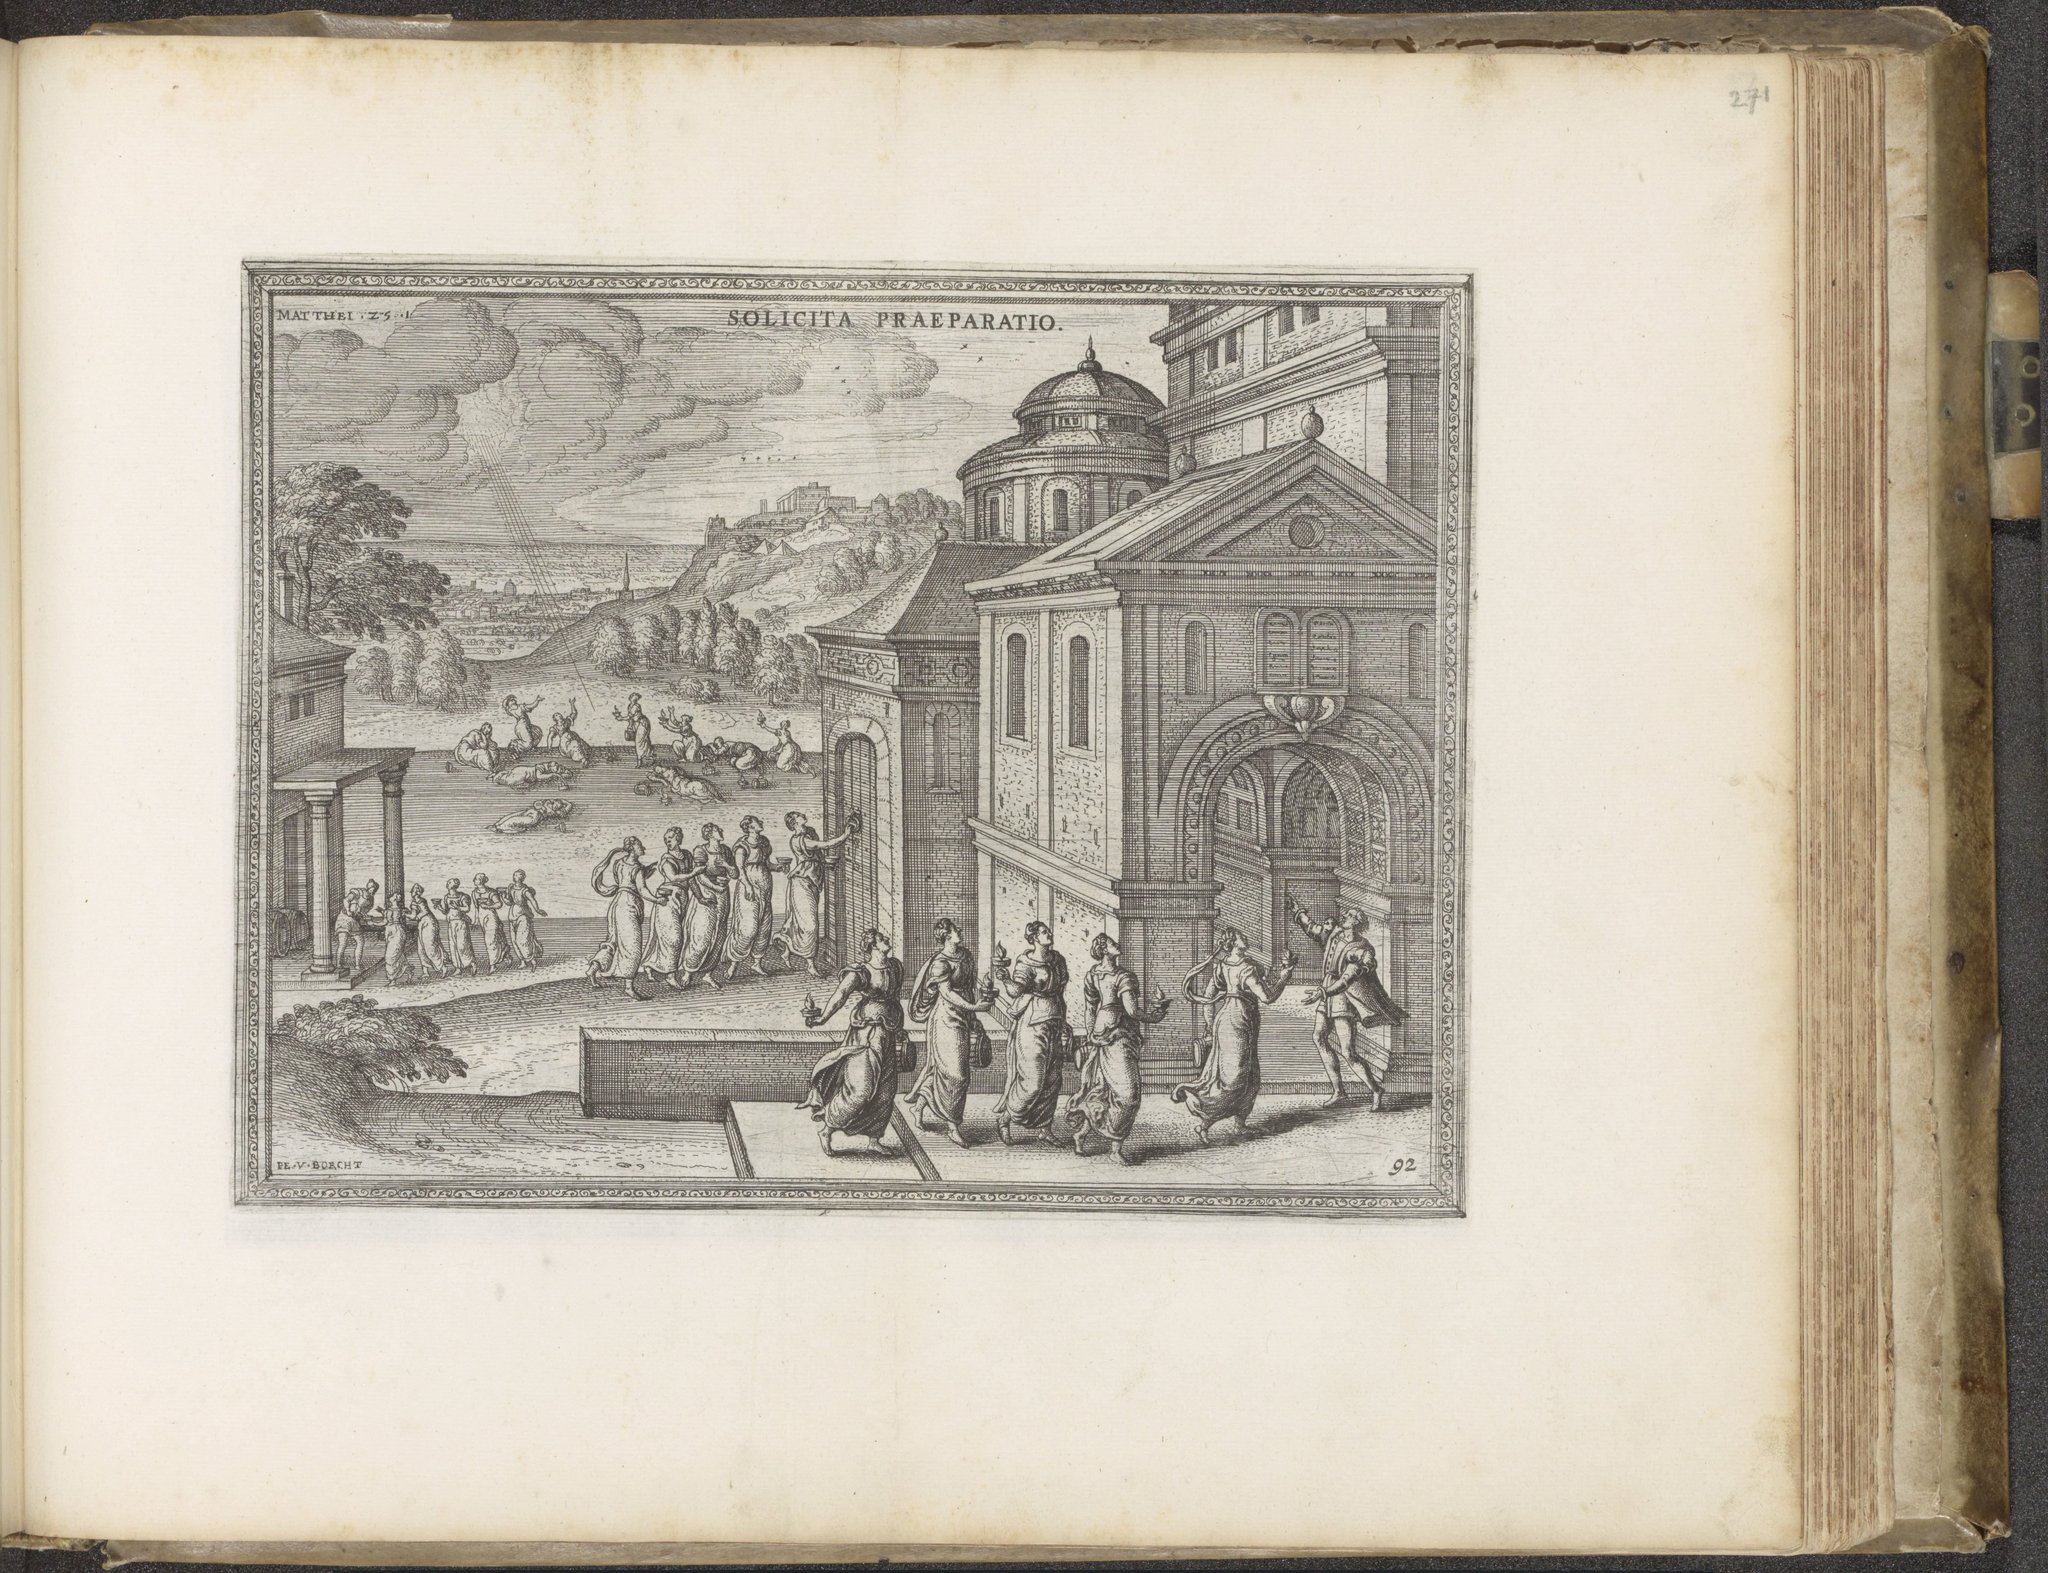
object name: print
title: Solicita praeparatio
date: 1582-1593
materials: paper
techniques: etching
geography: amsterdam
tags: the wise and the foolish virgins sleeping, the wise virgins are let into the house with the bridegroom (christ); the foolish virgins are shut out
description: Landschap met zeegezicht en de gelijkenis van de wijze en dwaze maagden. Tien meisjes waren erop uitgetrokken, de bruidegom tegemoet. Nadat ze hadden geslapen hadden vijf wijze maagden extra olie bij zich om hun lampen aan te steken. Op de voorgrond arriveren ze bij de bruidegom. Vijf dwaze maagden moesten eerst olie halen en kwamen voor een dichte deur te staan (Mat. 25). De prent maakt deel uit van een album.